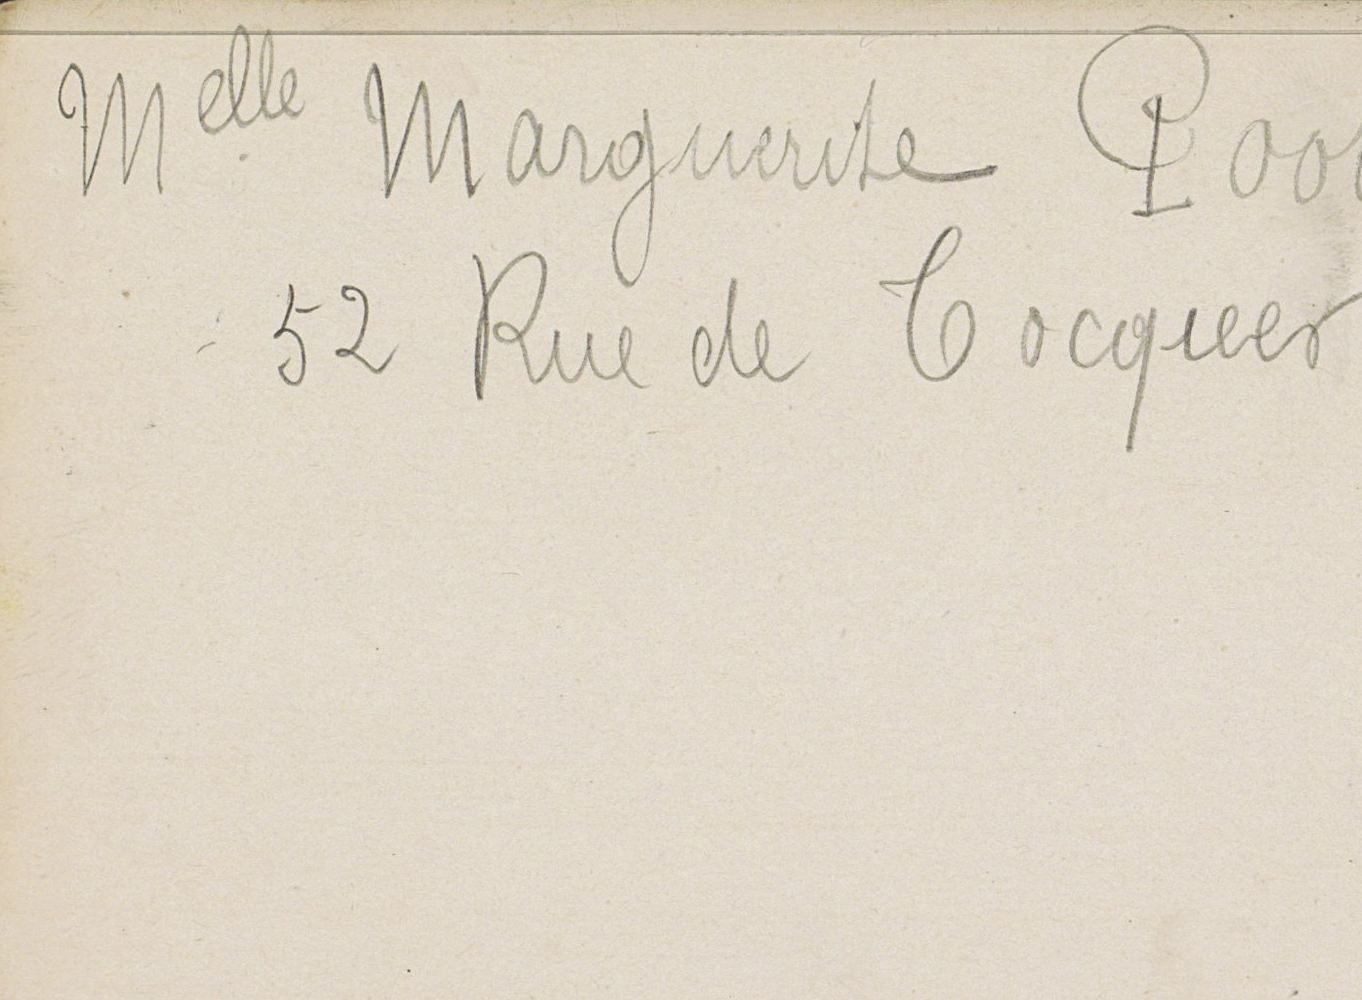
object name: sketchbook leaf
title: Annotaties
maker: isaac israels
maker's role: draughtsman, painter, print maker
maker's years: 1865-1934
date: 1875-1934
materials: paper, pencil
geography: paris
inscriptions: annotation: ‘Melle Marguerite Poot / 52 Rue de Cocquerelle’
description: Pagina 5 uit schetsboek XLV met 85 pagina's.